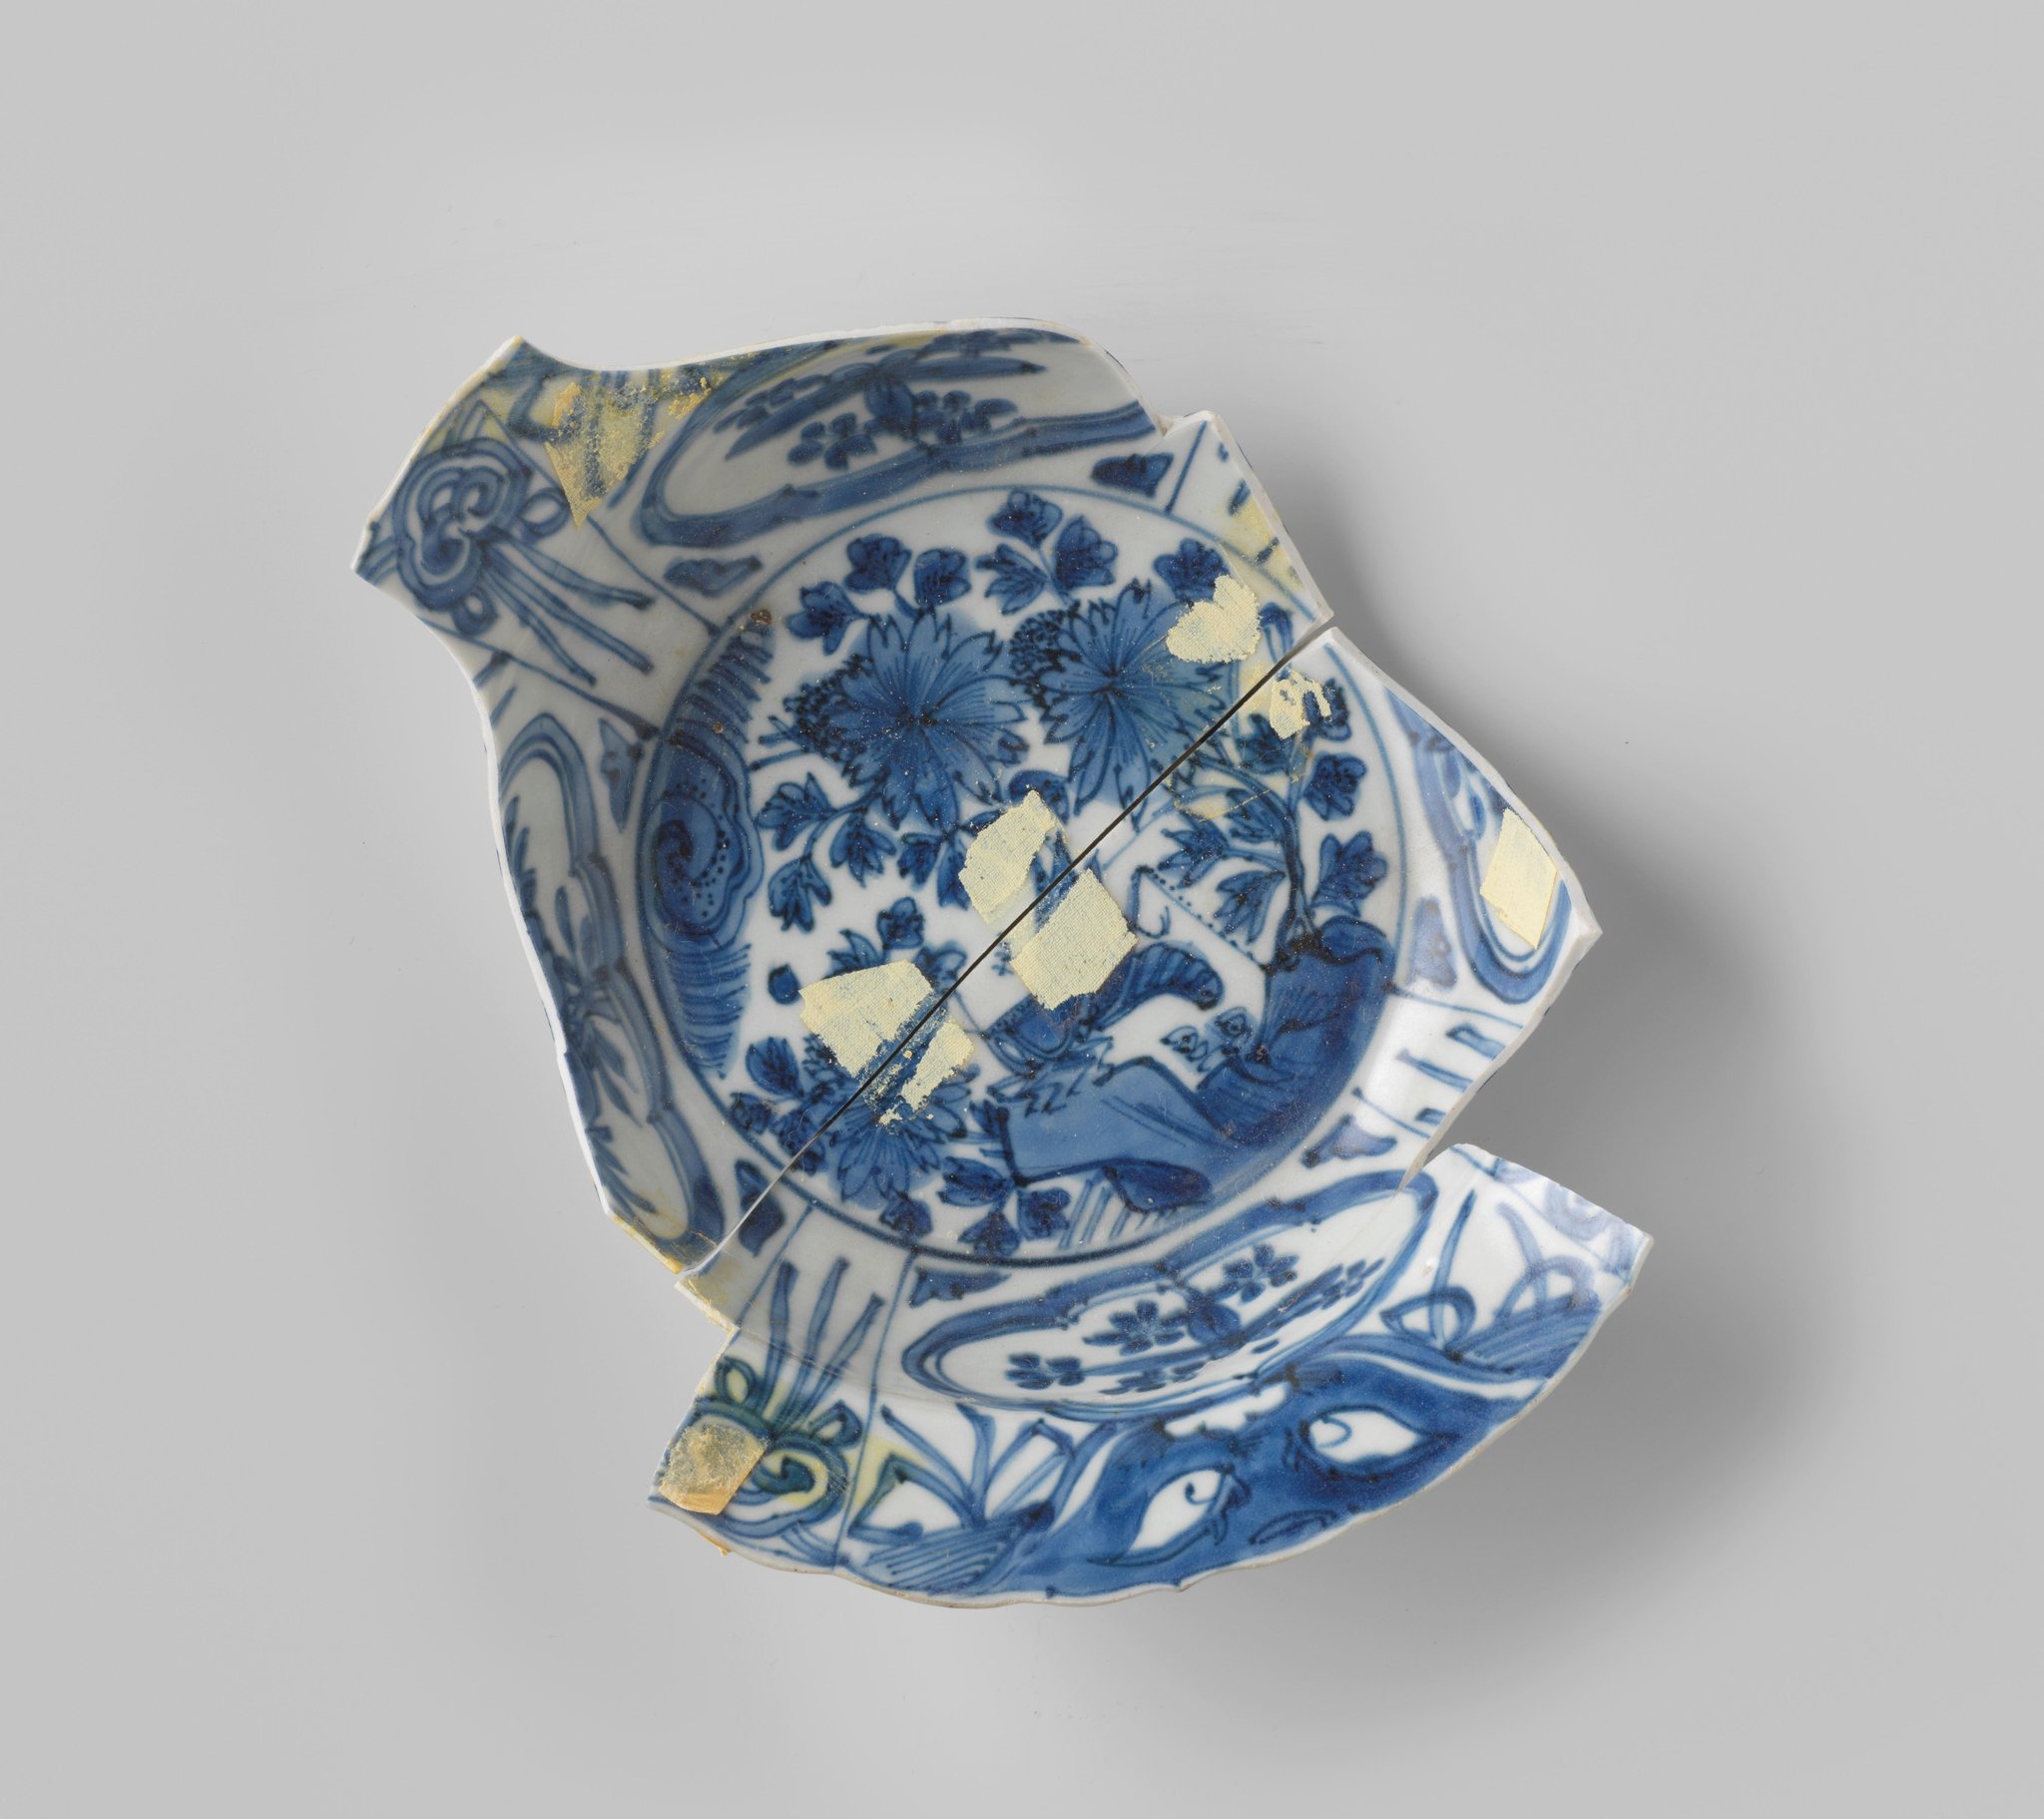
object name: deep dish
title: Diep bord uit V.O.C.-schip de 'Witte Leeuw'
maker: Anonymous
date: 1613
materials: bone china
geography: jingdezhen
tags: verenigde oostindische compagnie, sint-helena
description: A bowl with a flattened rim. Taotie mask and/or borders with diaper patterns. A central decoration of a grasshopper on a rock next to a peony. Panels decorated with flowers and fruits.